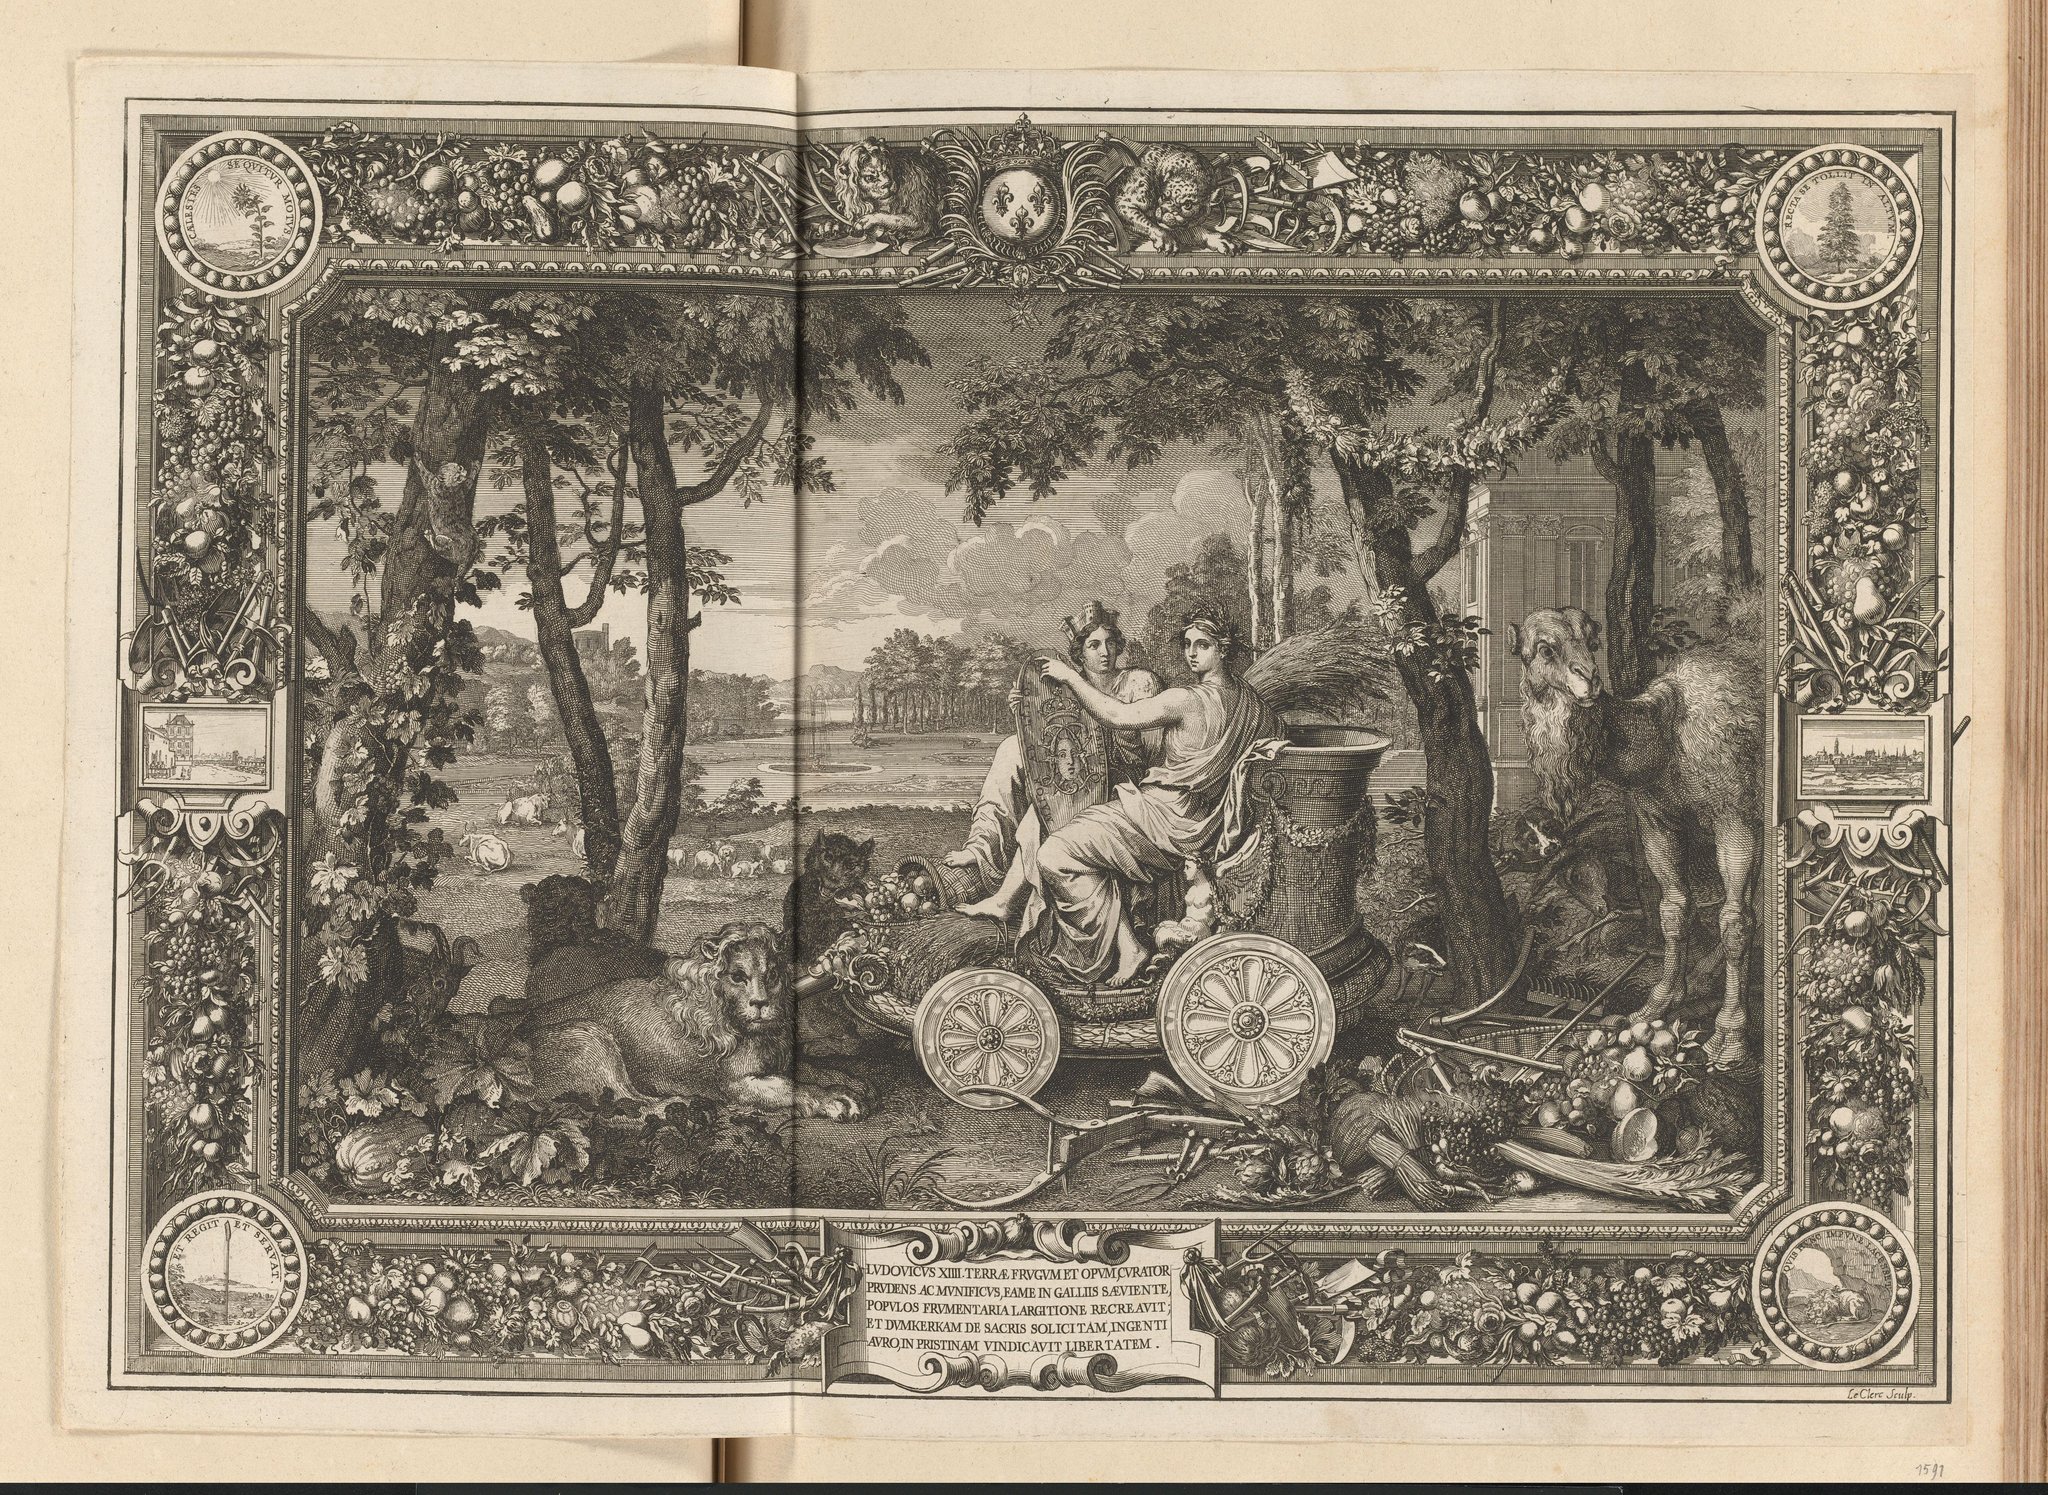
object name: book illustration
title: Allegorie op het element aarde, in een cartouche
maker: sébastien leclerc (i)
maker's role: print maker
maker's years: 1637-1714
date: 1670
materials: paper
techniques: engraving, etching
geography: paris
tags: harvest, (story of) ceres (demeter), (story of) cybele, rhea cybele, great mother of the gods (berecynt(h)ia), earth (one of the four elements)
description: Prent gebruikt voor: Félibien, André. Devises pour les tapisseries du Roy, où sont représentez les quatre éléments et les quatre saisons de l'année (...). Parijs: Imprimerie Royale, 1670.